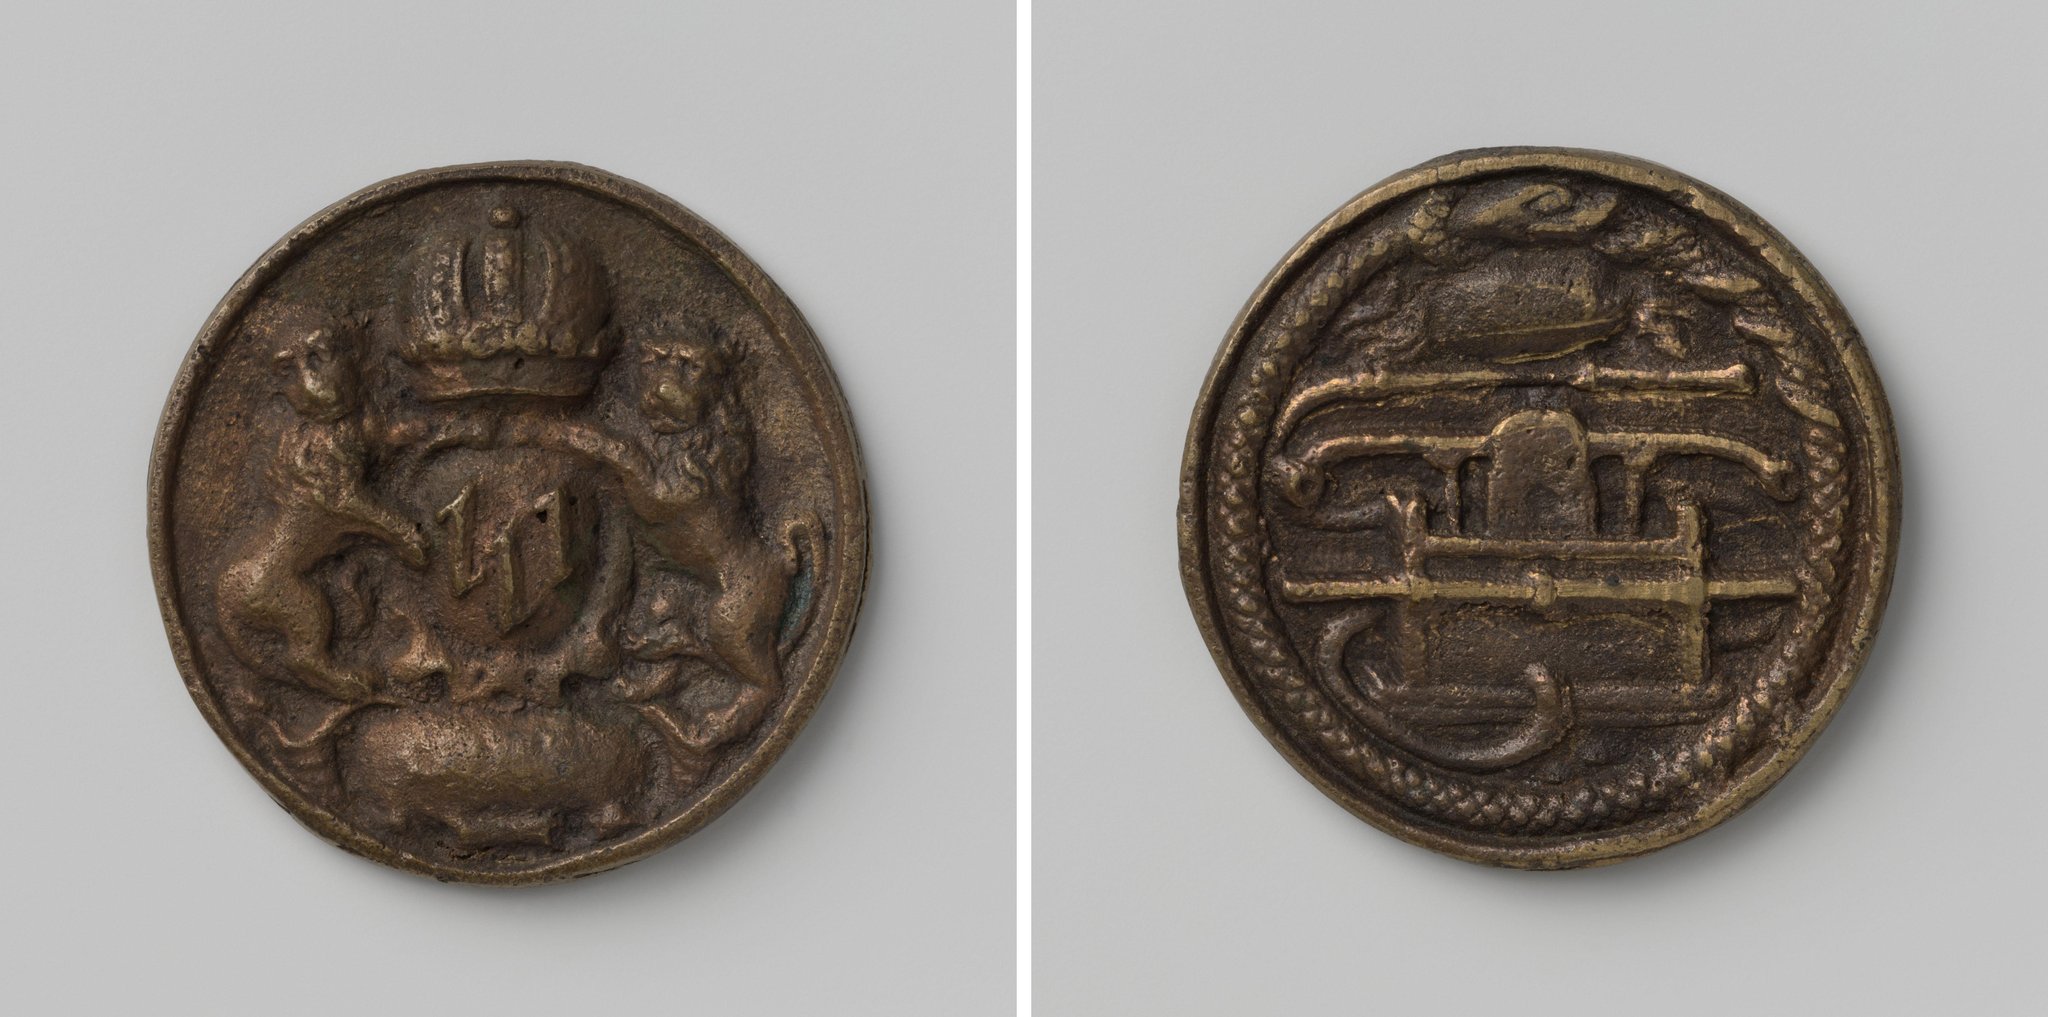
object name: fire engine medal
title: Purmerend, brandspuitpenning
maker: Anonymous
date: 1680-1800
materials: brass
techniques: casting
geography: purmerend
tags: purmerend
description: Messing penning. Voorzijde: gekroond wapenschild geflankeerd door twee leeuwen boven leeg cartouche. Keerzijde: brandspuit onder leeg cartouche binnen slangerond